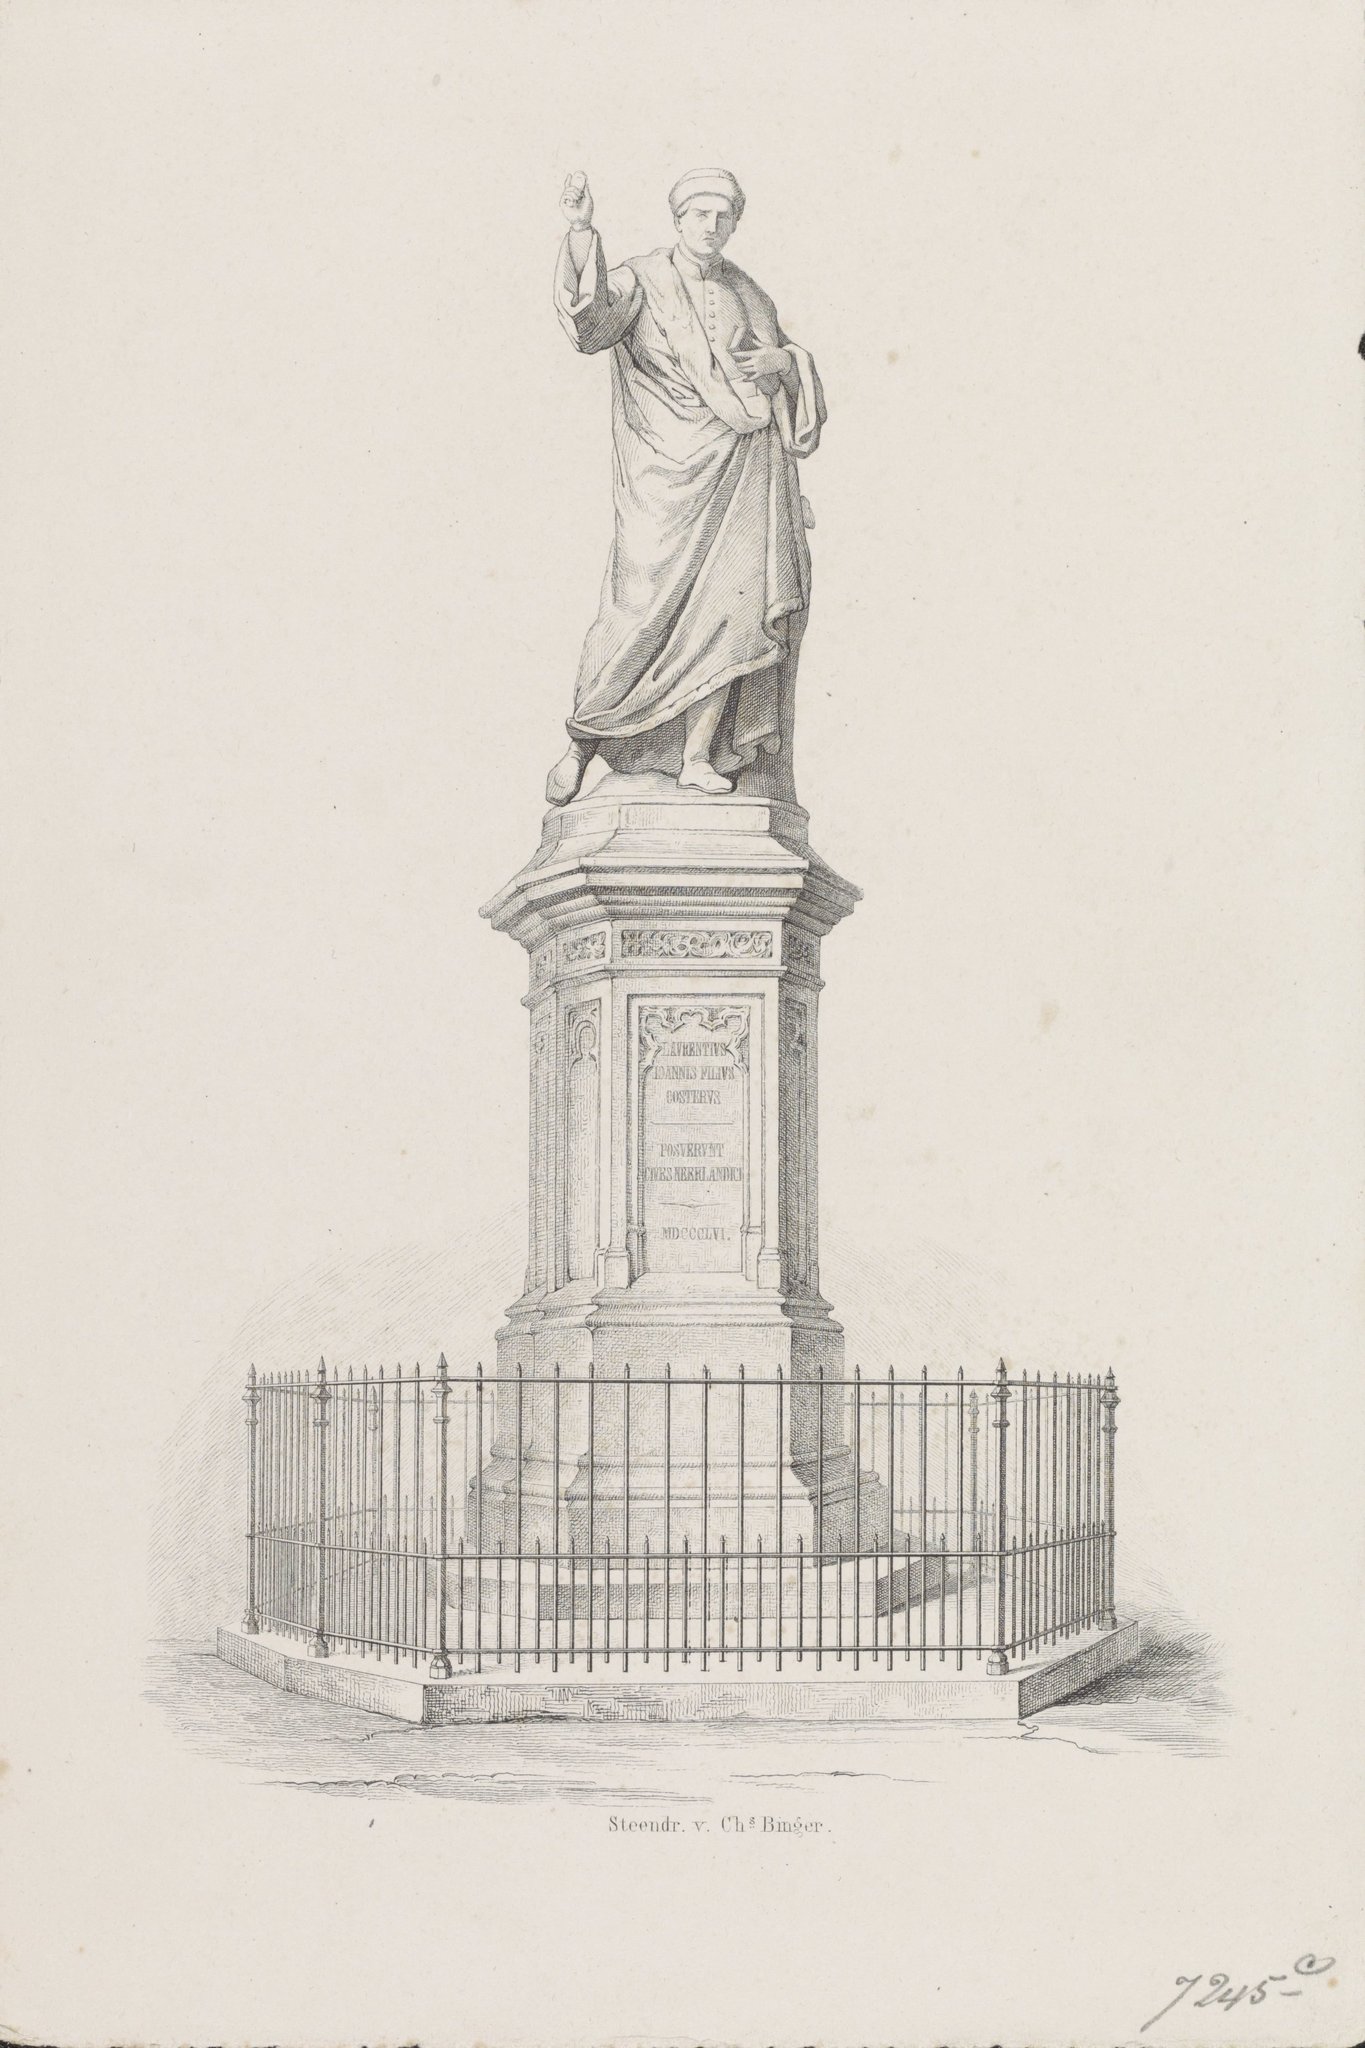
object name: print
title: Standbeeld van Coster in Haarlem, 1856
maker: charles binger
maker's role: print maker, printer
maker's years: 1830-1916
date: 1856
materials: paper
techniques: lithograph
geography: haarlem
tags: monument, statue, haarlem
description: Het standbeeld van Laurens Coster op de Grote Markt te Haarlem, onthuld 15-17 juli 1856.